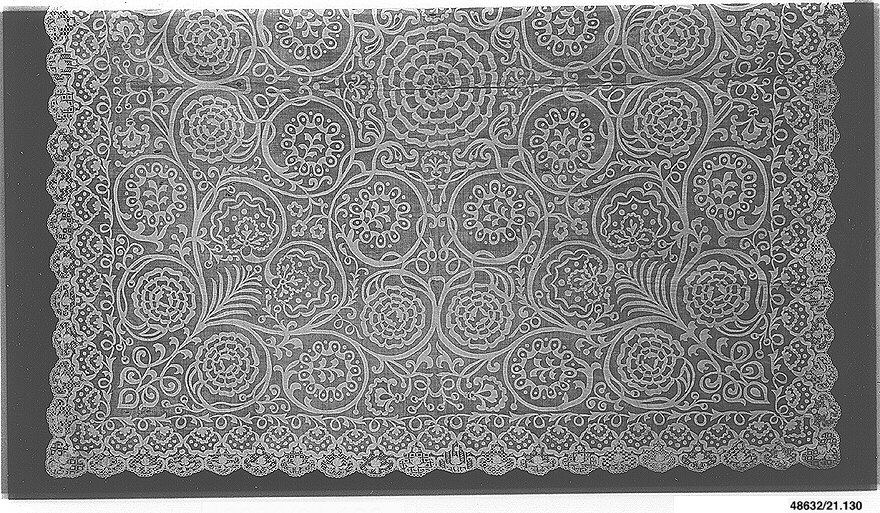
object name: kerchief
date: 1801-1900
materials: fiber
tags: flowers